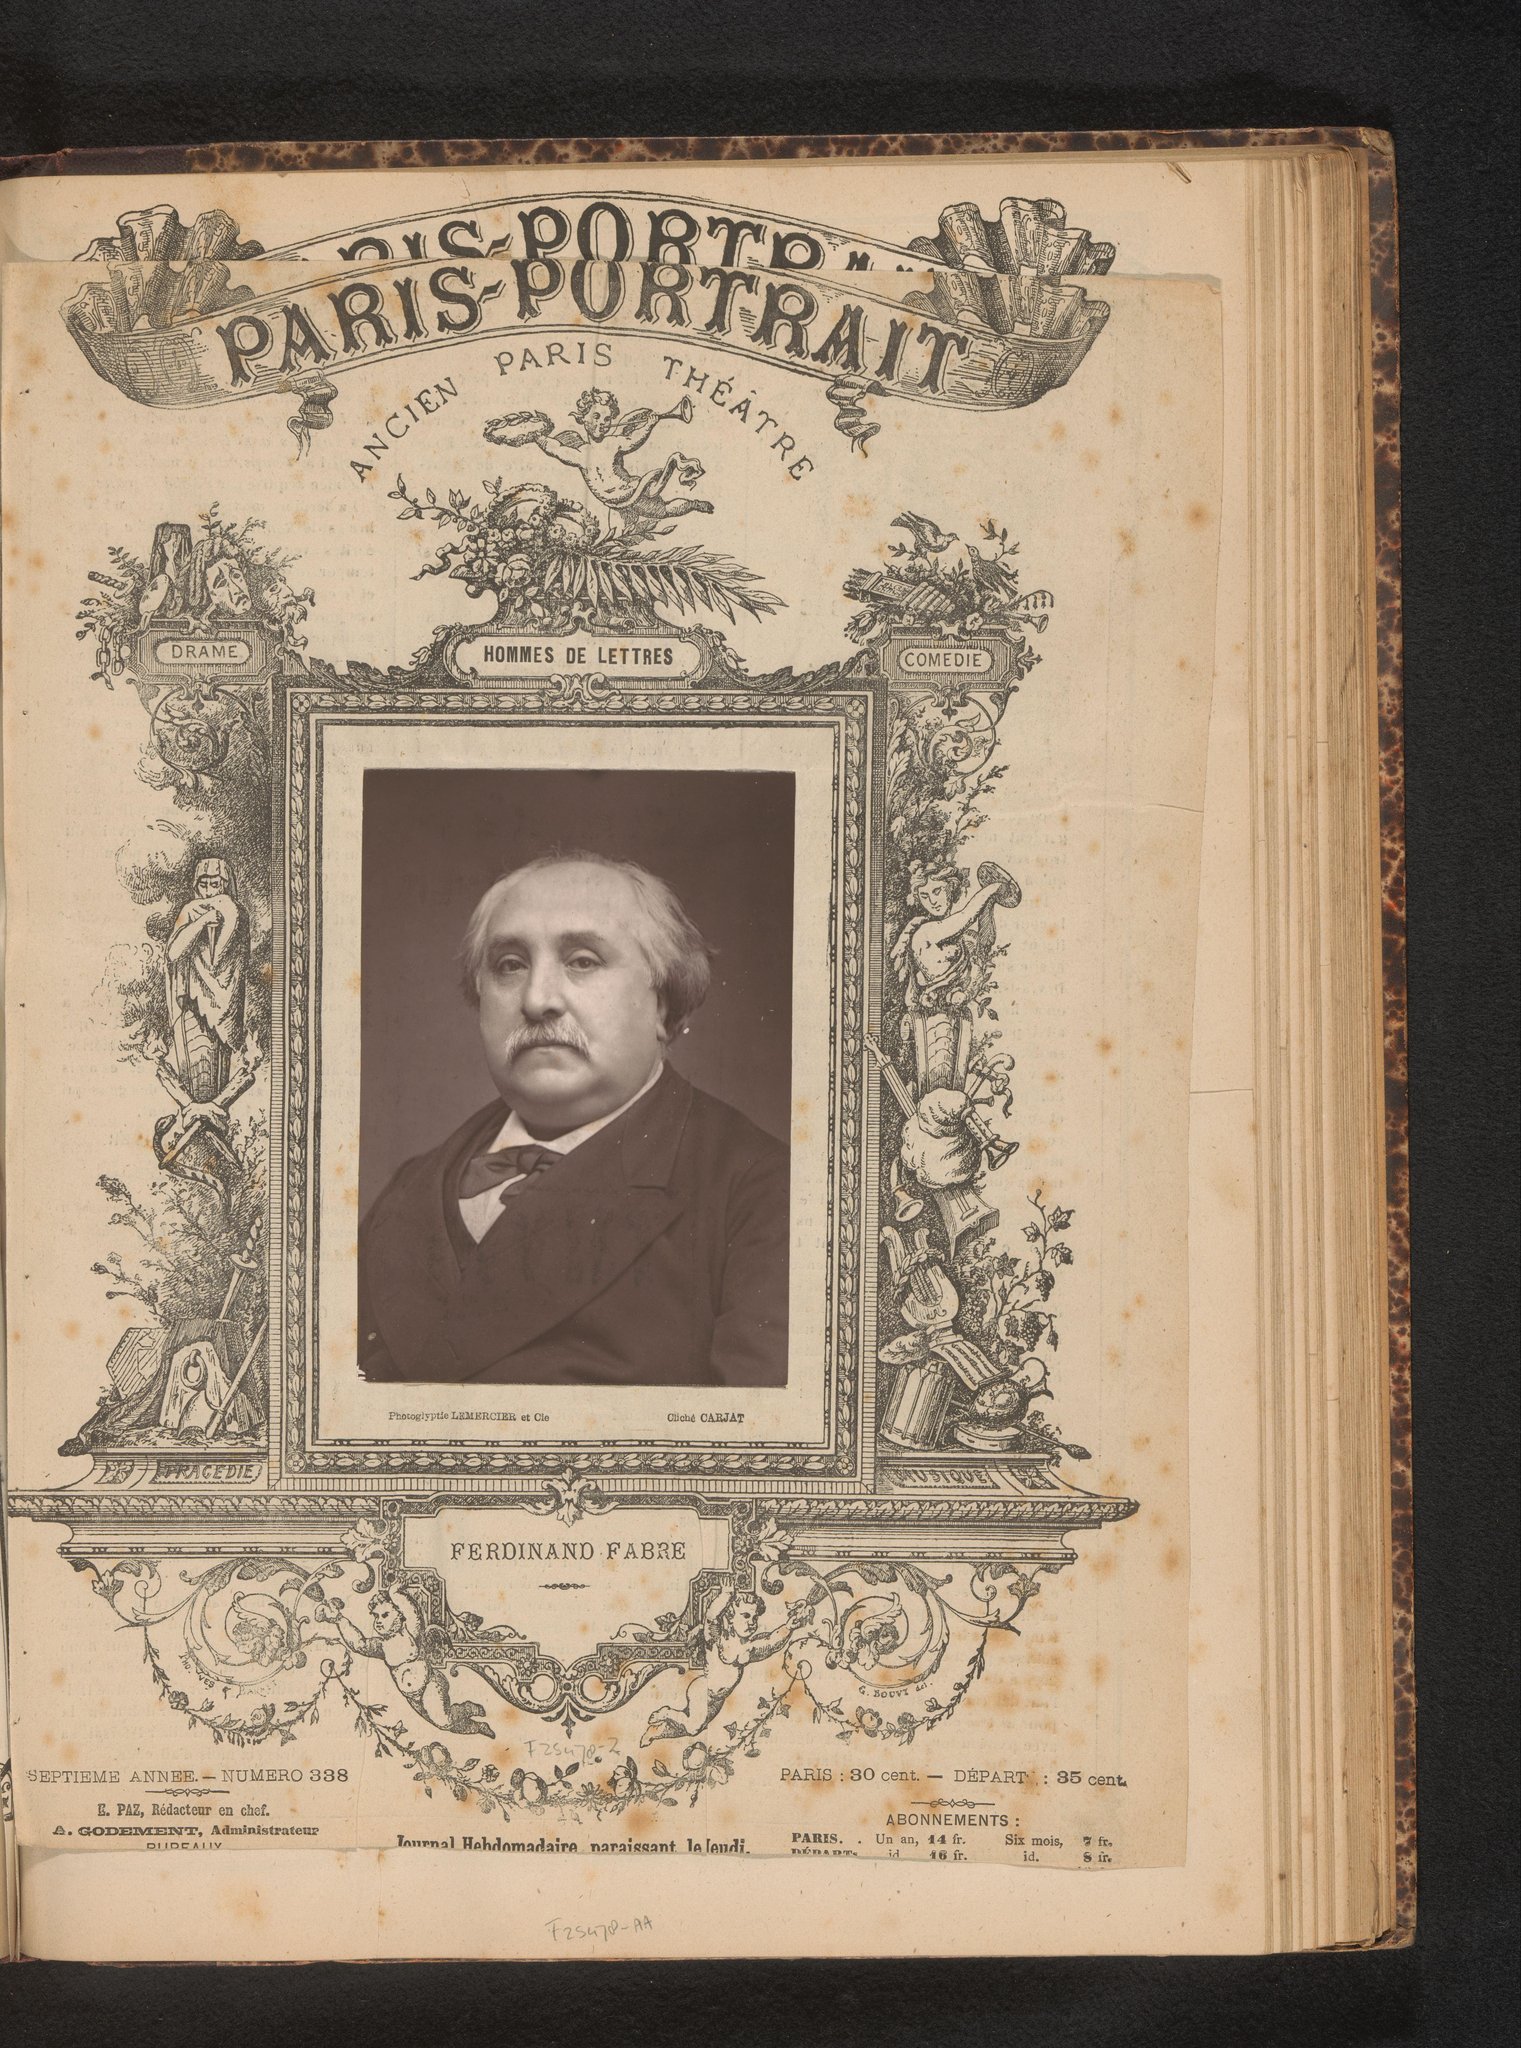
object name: photomechanical print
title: Portret van Ferdinand Fabre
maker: étienne carjat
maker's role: draughtsman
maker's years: 1828-1906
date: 1873-1880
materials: paper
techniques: woodburytype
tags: paris, historical persons